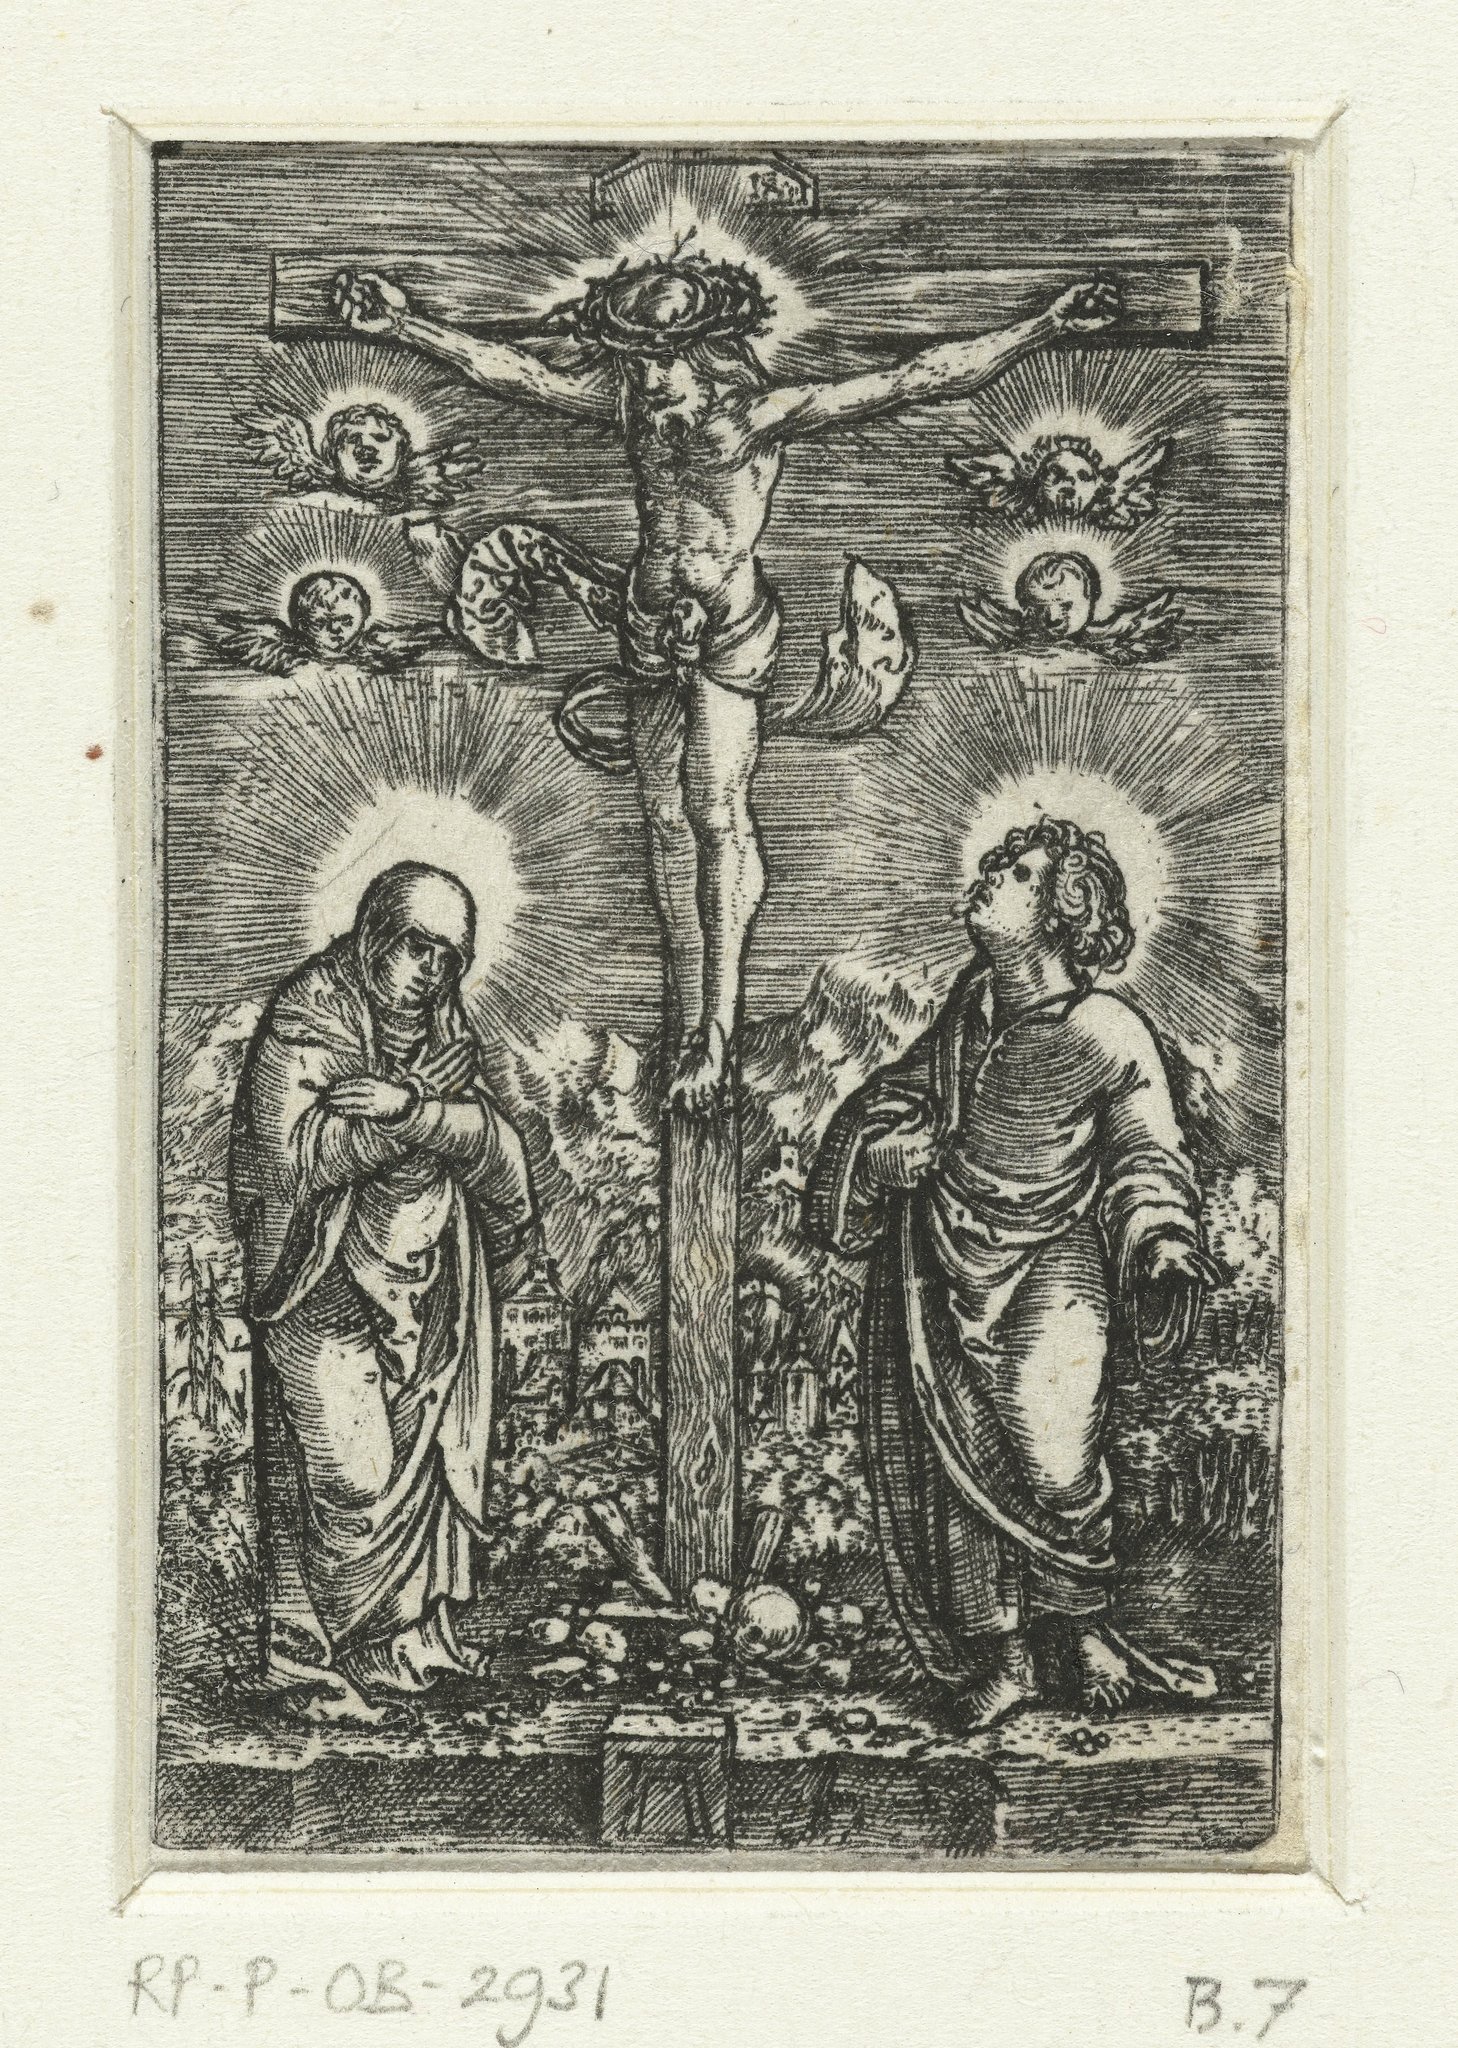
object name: print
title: Christus aan het kruis tussen Maria en Johannes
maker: albrecht altdorfer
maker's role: draughtsman, print maker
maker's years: 1480-1538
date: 1506-1538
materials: paper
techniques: engraving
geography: germany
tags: crucified christ with mary and john on either side of the cross; holy rood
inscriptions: number: ‘46’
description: Christus aan het kruis, met rechts van hem Maria en links Johannes. In de lucht vier cherubijnen.